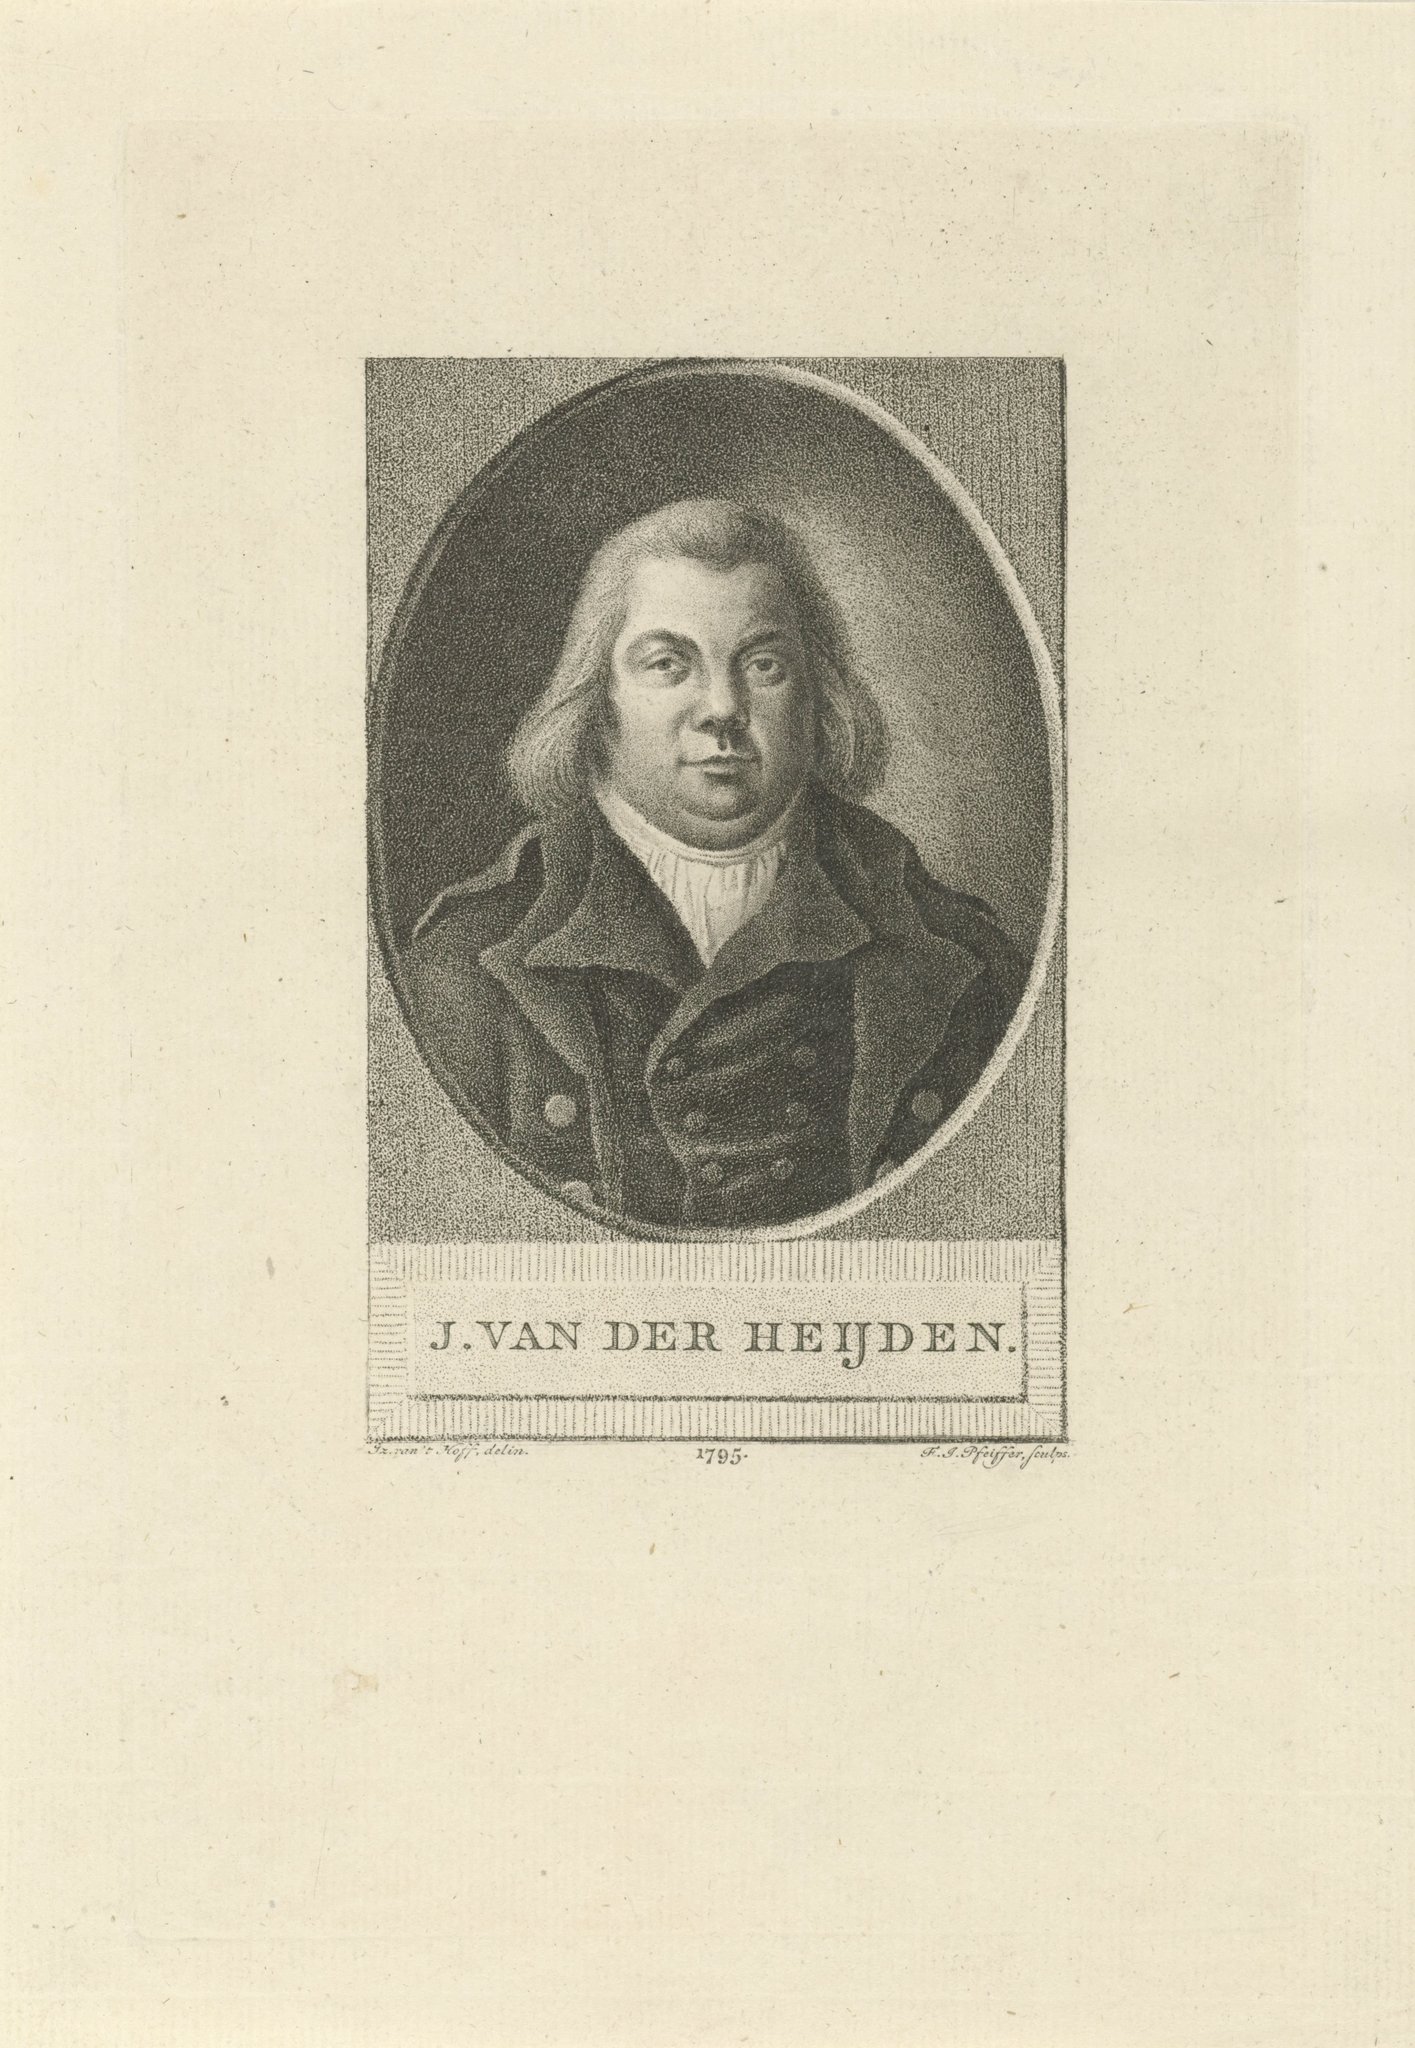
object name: print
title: Portret van J. van der Heijden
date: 1795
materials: paper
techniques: aquatint, etching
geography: amsterdam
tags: j. van der heijden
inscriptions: collector's mark: Lugt 2228